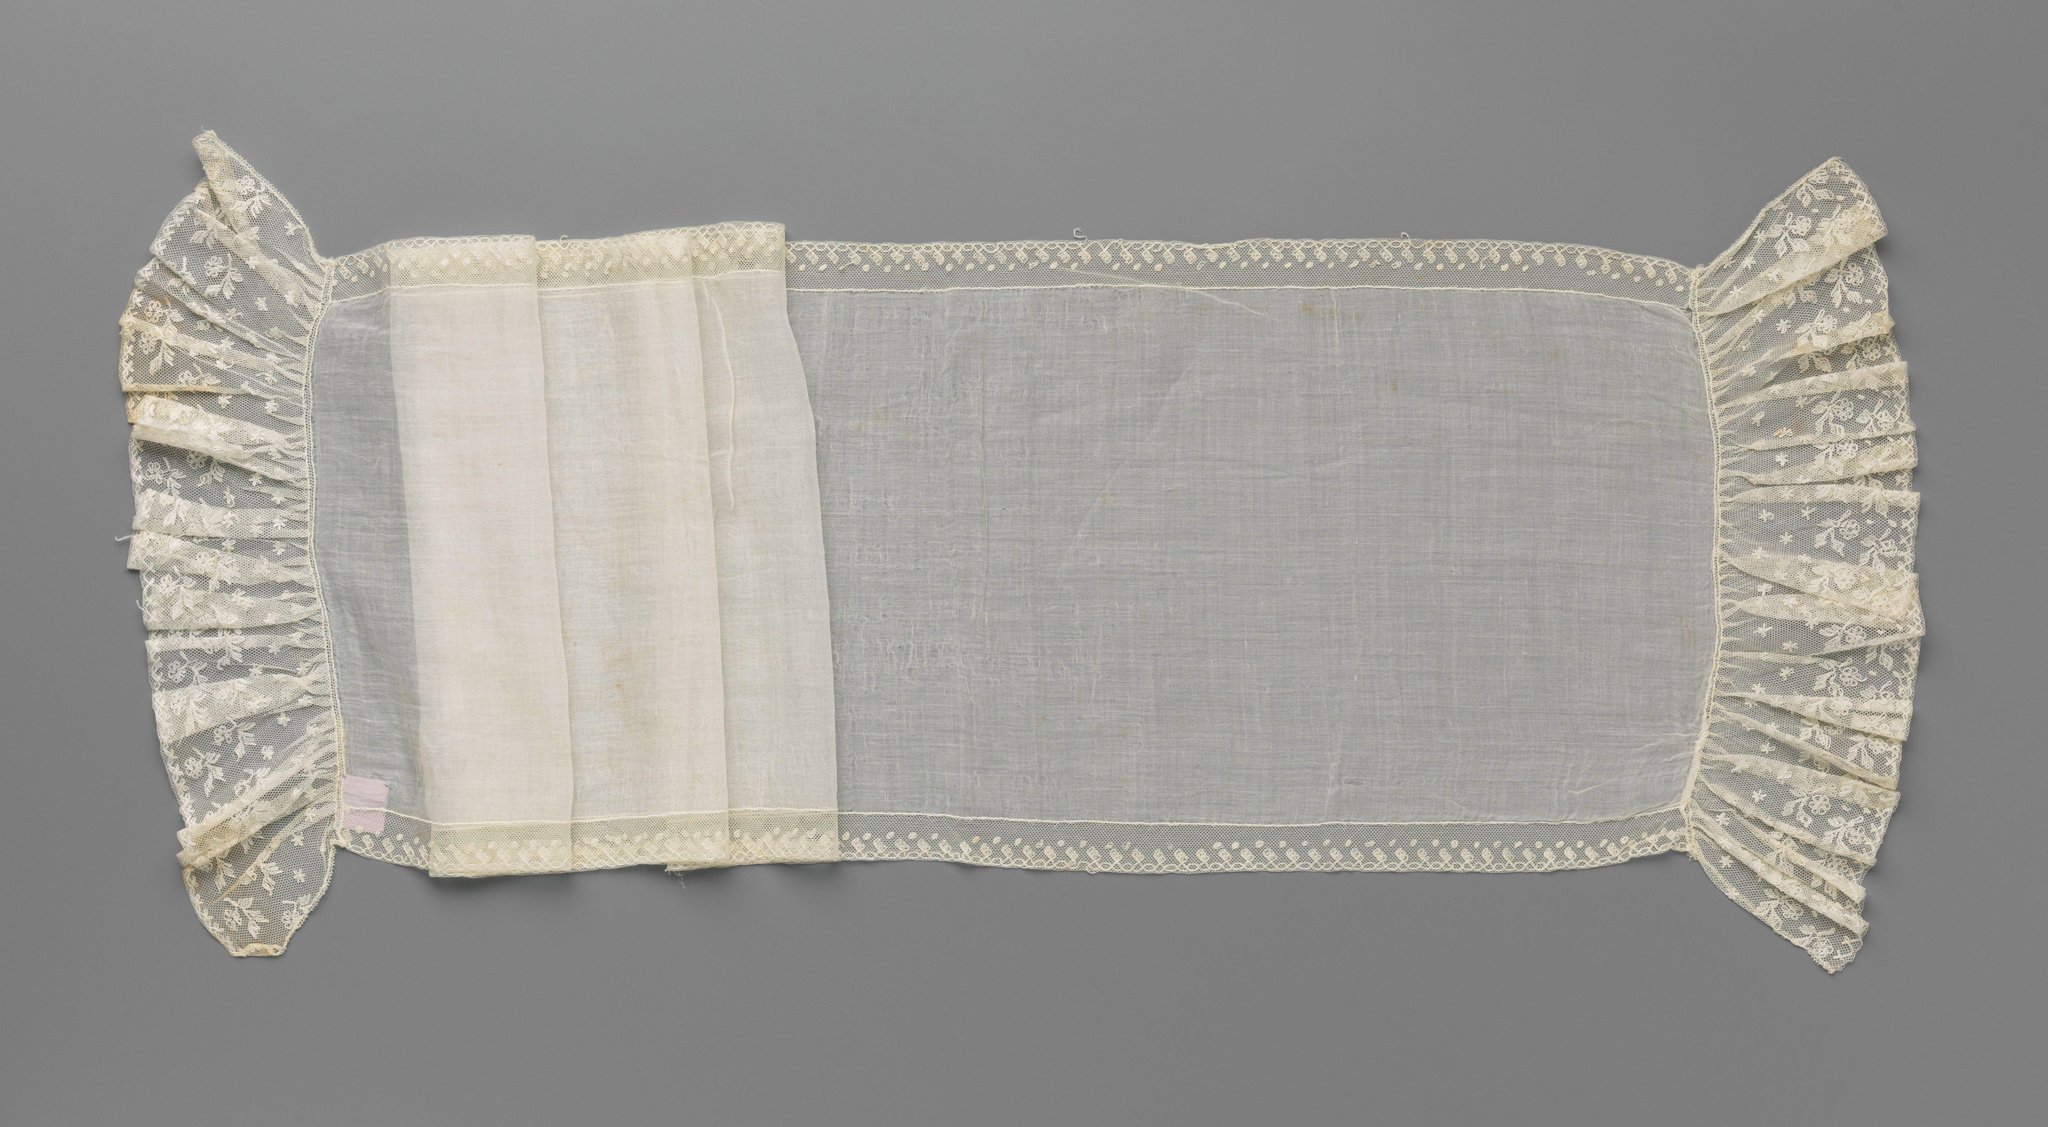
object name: womenswear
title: Das afgezet met stroken kantborduurwerk op machinale tule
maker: Anonymous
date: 1850-1899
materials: linen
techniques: weave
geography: europe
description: Das van onbewerkte naturelkleurige batist met langs de lange zijden een smalle strook kantborduurwerk: tuledoorstopwerk op machinale tule. Patroon met moesjes boven een rand met ovaaltjes met pluimpjes. Aan de korte zijden is gerimpelde brede strook tuledoorstopwerk op machinale tule gezet, met een patroon van bloemtakken en gestrooide sterren.